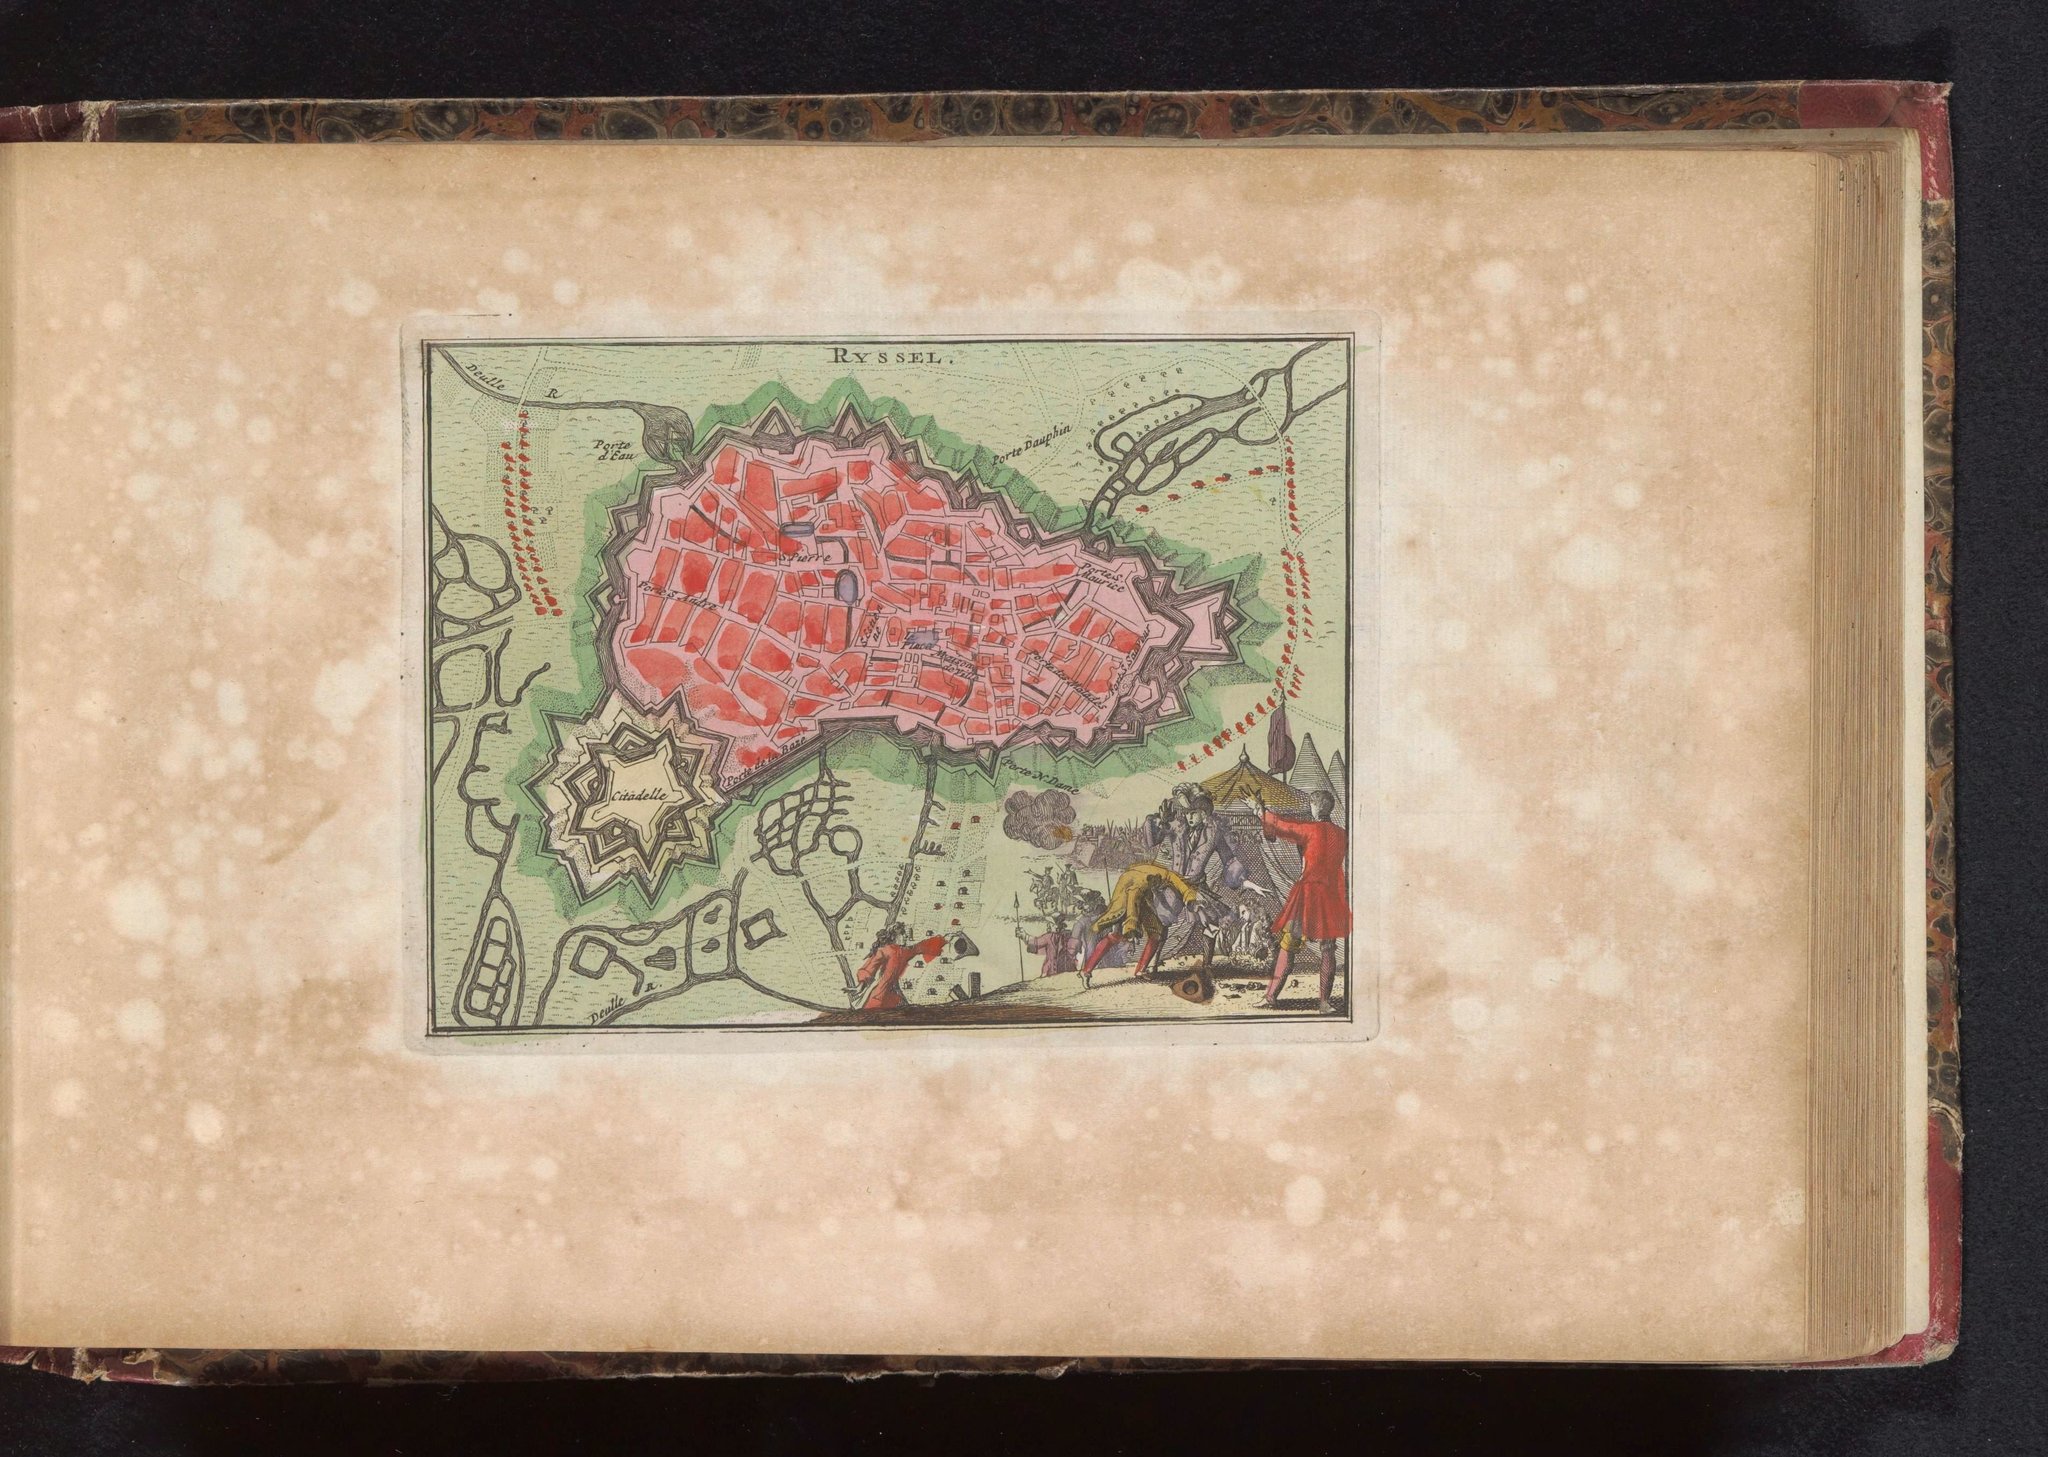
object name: print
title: Plattegrond van Lille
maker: Anonymous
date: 1735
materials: paper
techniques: engraving, etching, hand coloring, lacquer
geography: amsterdam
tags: fortified city, maps of cities, lille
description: Plattegrond van de versterkingen om de stad Lille (Rijssel). Rechtsonder buigt een man, mogelijk een bode, voor een bevelhebber voor zijn legertent. Onderdeel van een atlas met 223 kaarten van landen en steden en oorlogstaferelen in Europa in de periode ca. 1690-1735.